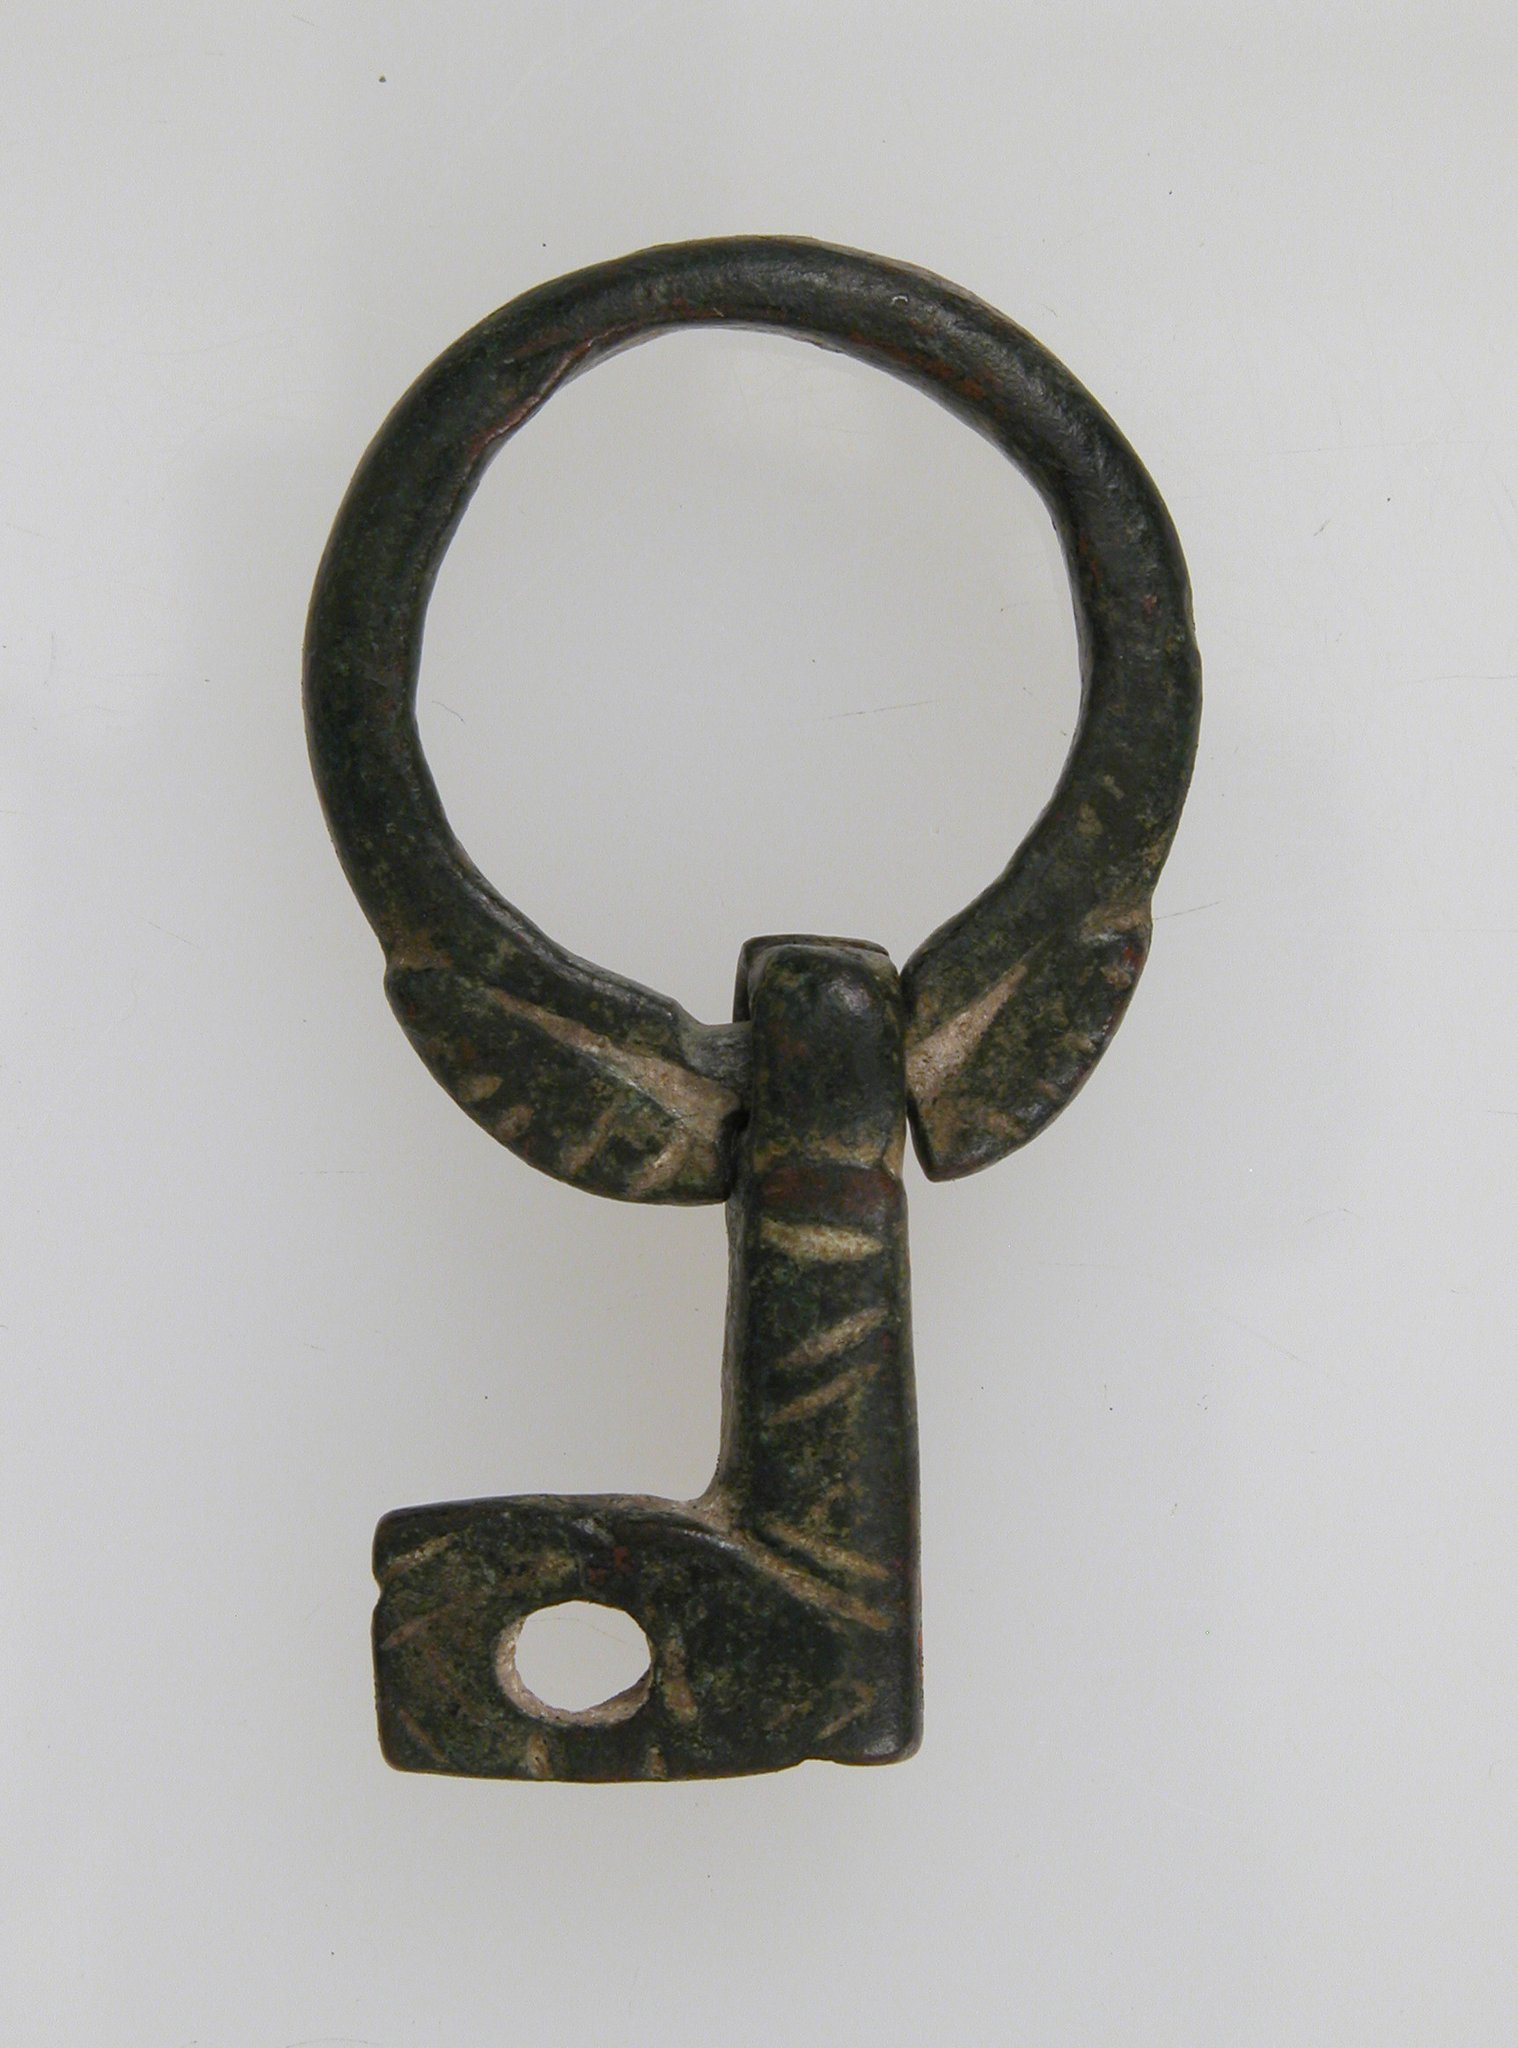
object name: key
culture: roman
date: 201-500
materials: copper alloy, iron